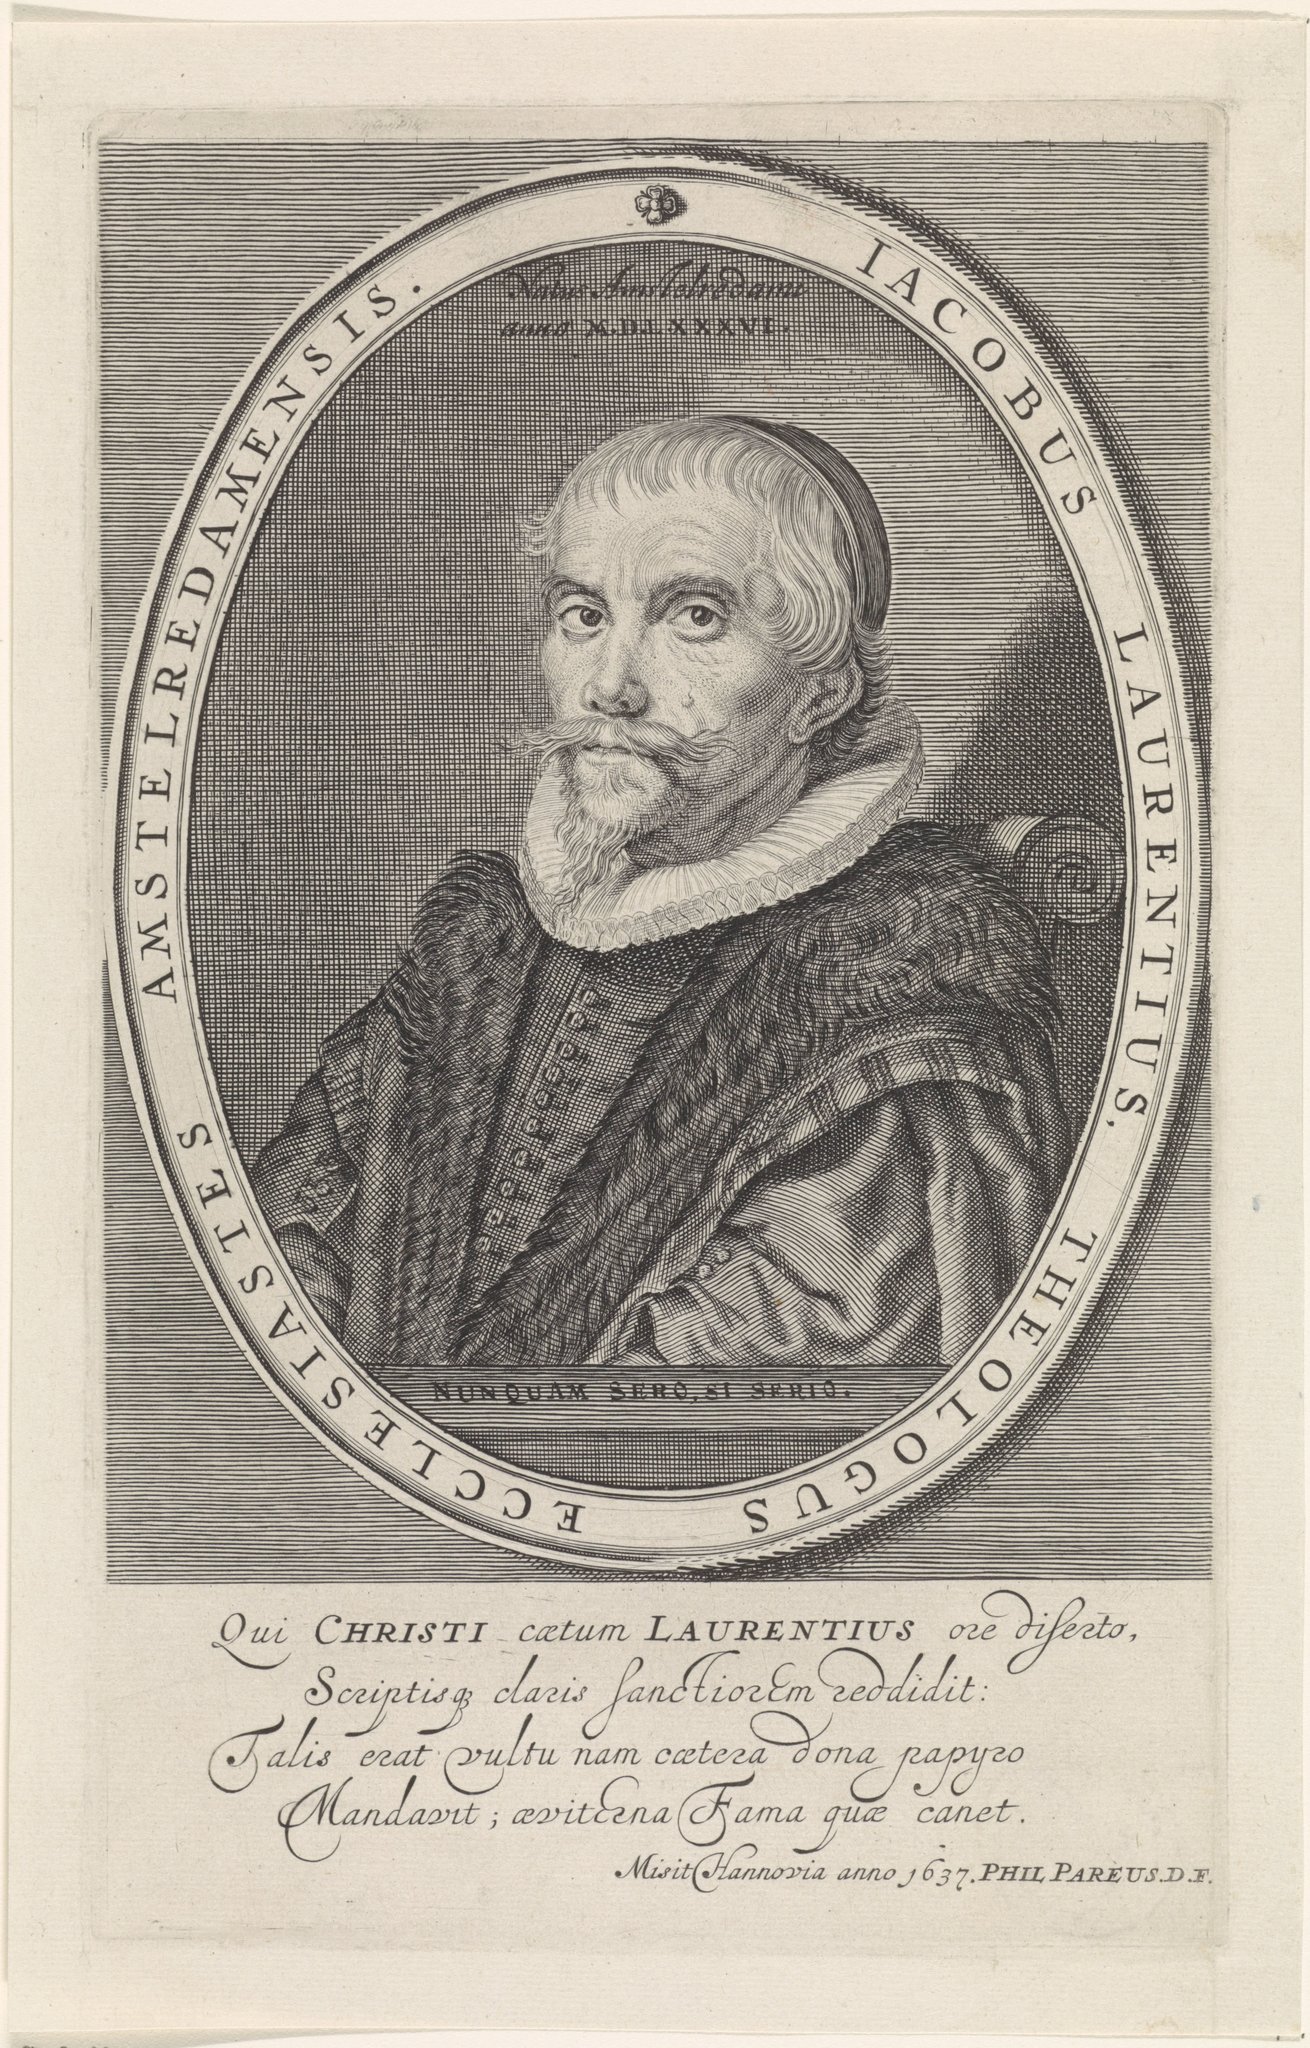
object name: print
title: Portret van Jacobus Laurentius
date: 1642-1692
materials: paper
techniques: engraving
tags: amsterdam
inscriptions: collector's mark: Lugt 240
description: Portret van de Amsterdamse theoloog Jacobus Laurentius.